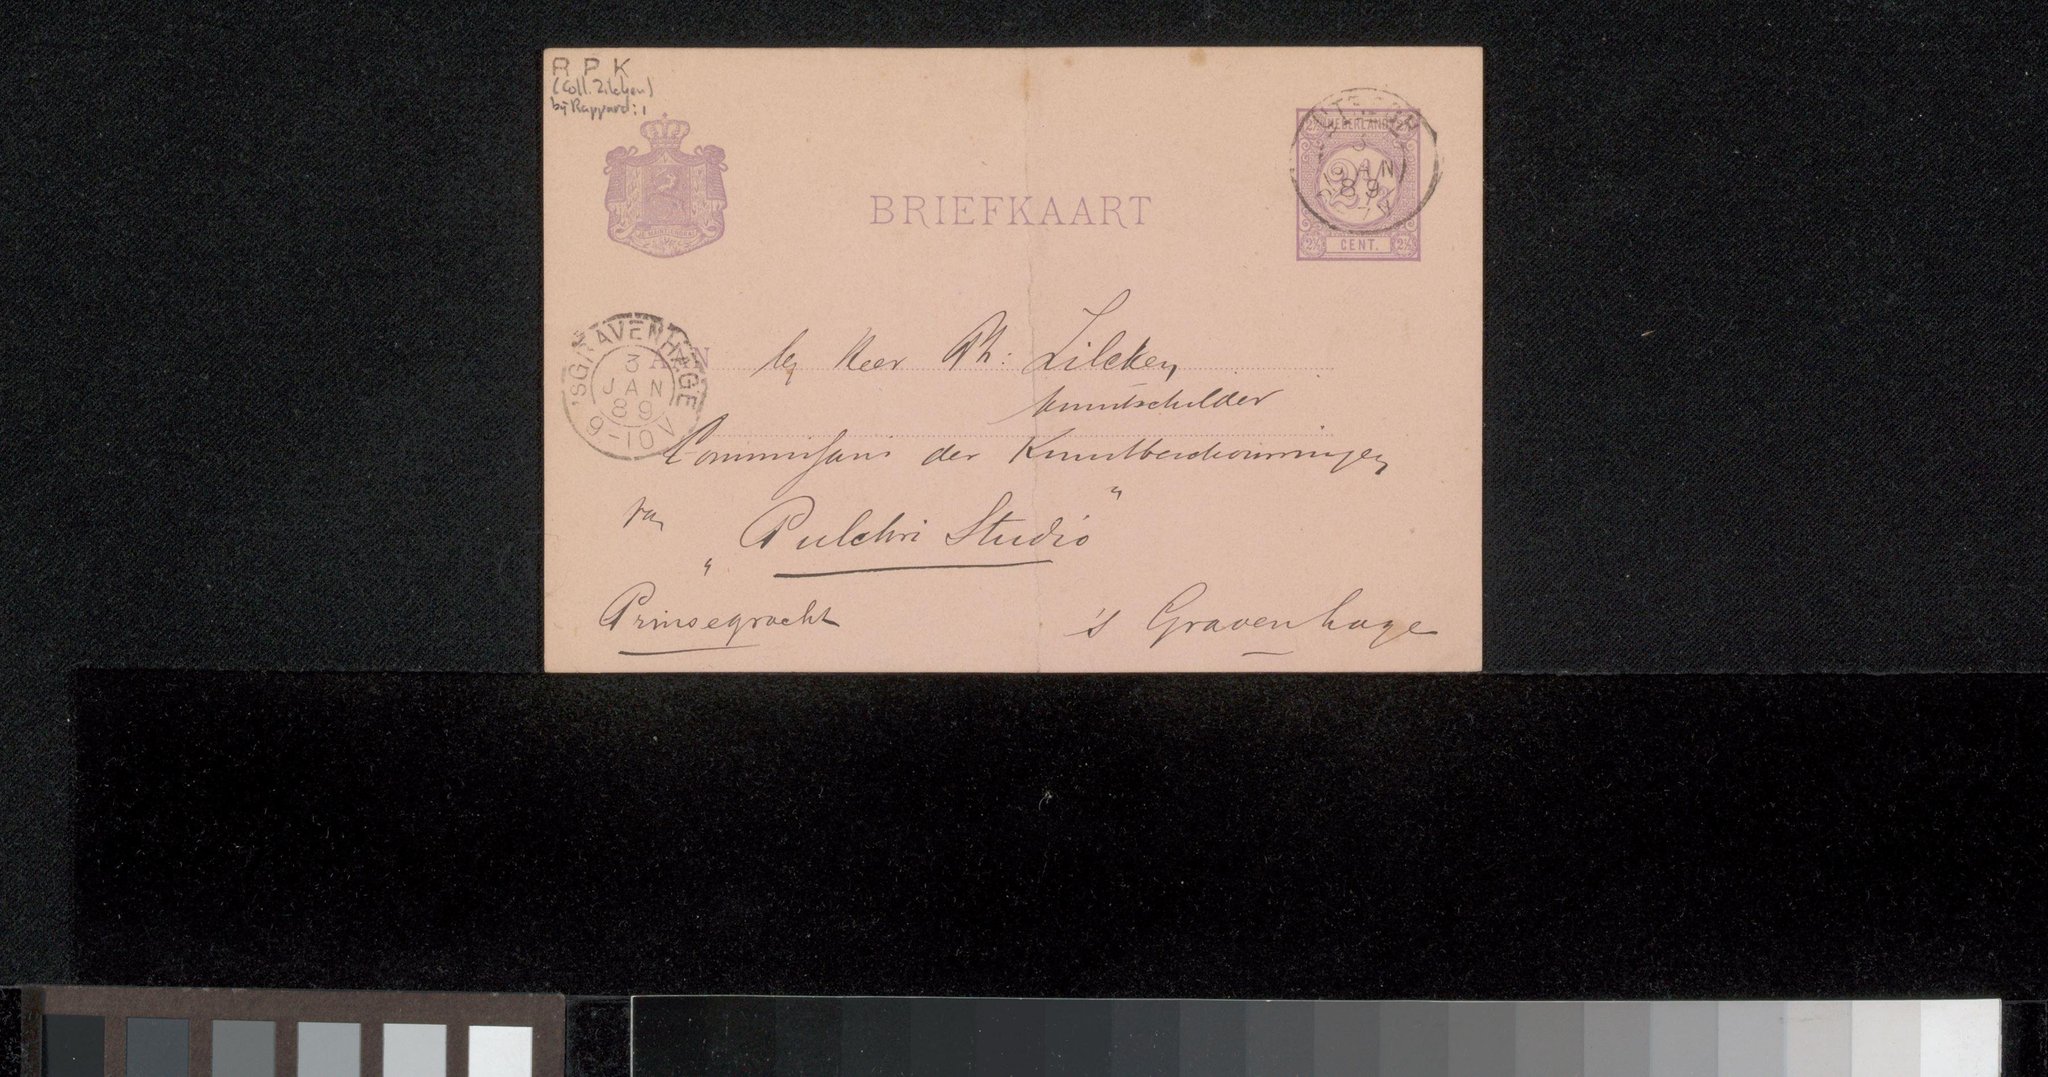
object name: postcard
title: Briefkaart aan Philip Zilcken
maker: anthon gerhard alexander van rappard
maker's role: draughtsman, print maker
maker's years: 1858-1892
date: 1889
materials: cardboard, ink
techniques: pen, writing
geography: utrecht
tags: painter, philip zilcken, drawing, money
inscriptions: collector's mark: ‘RPK’